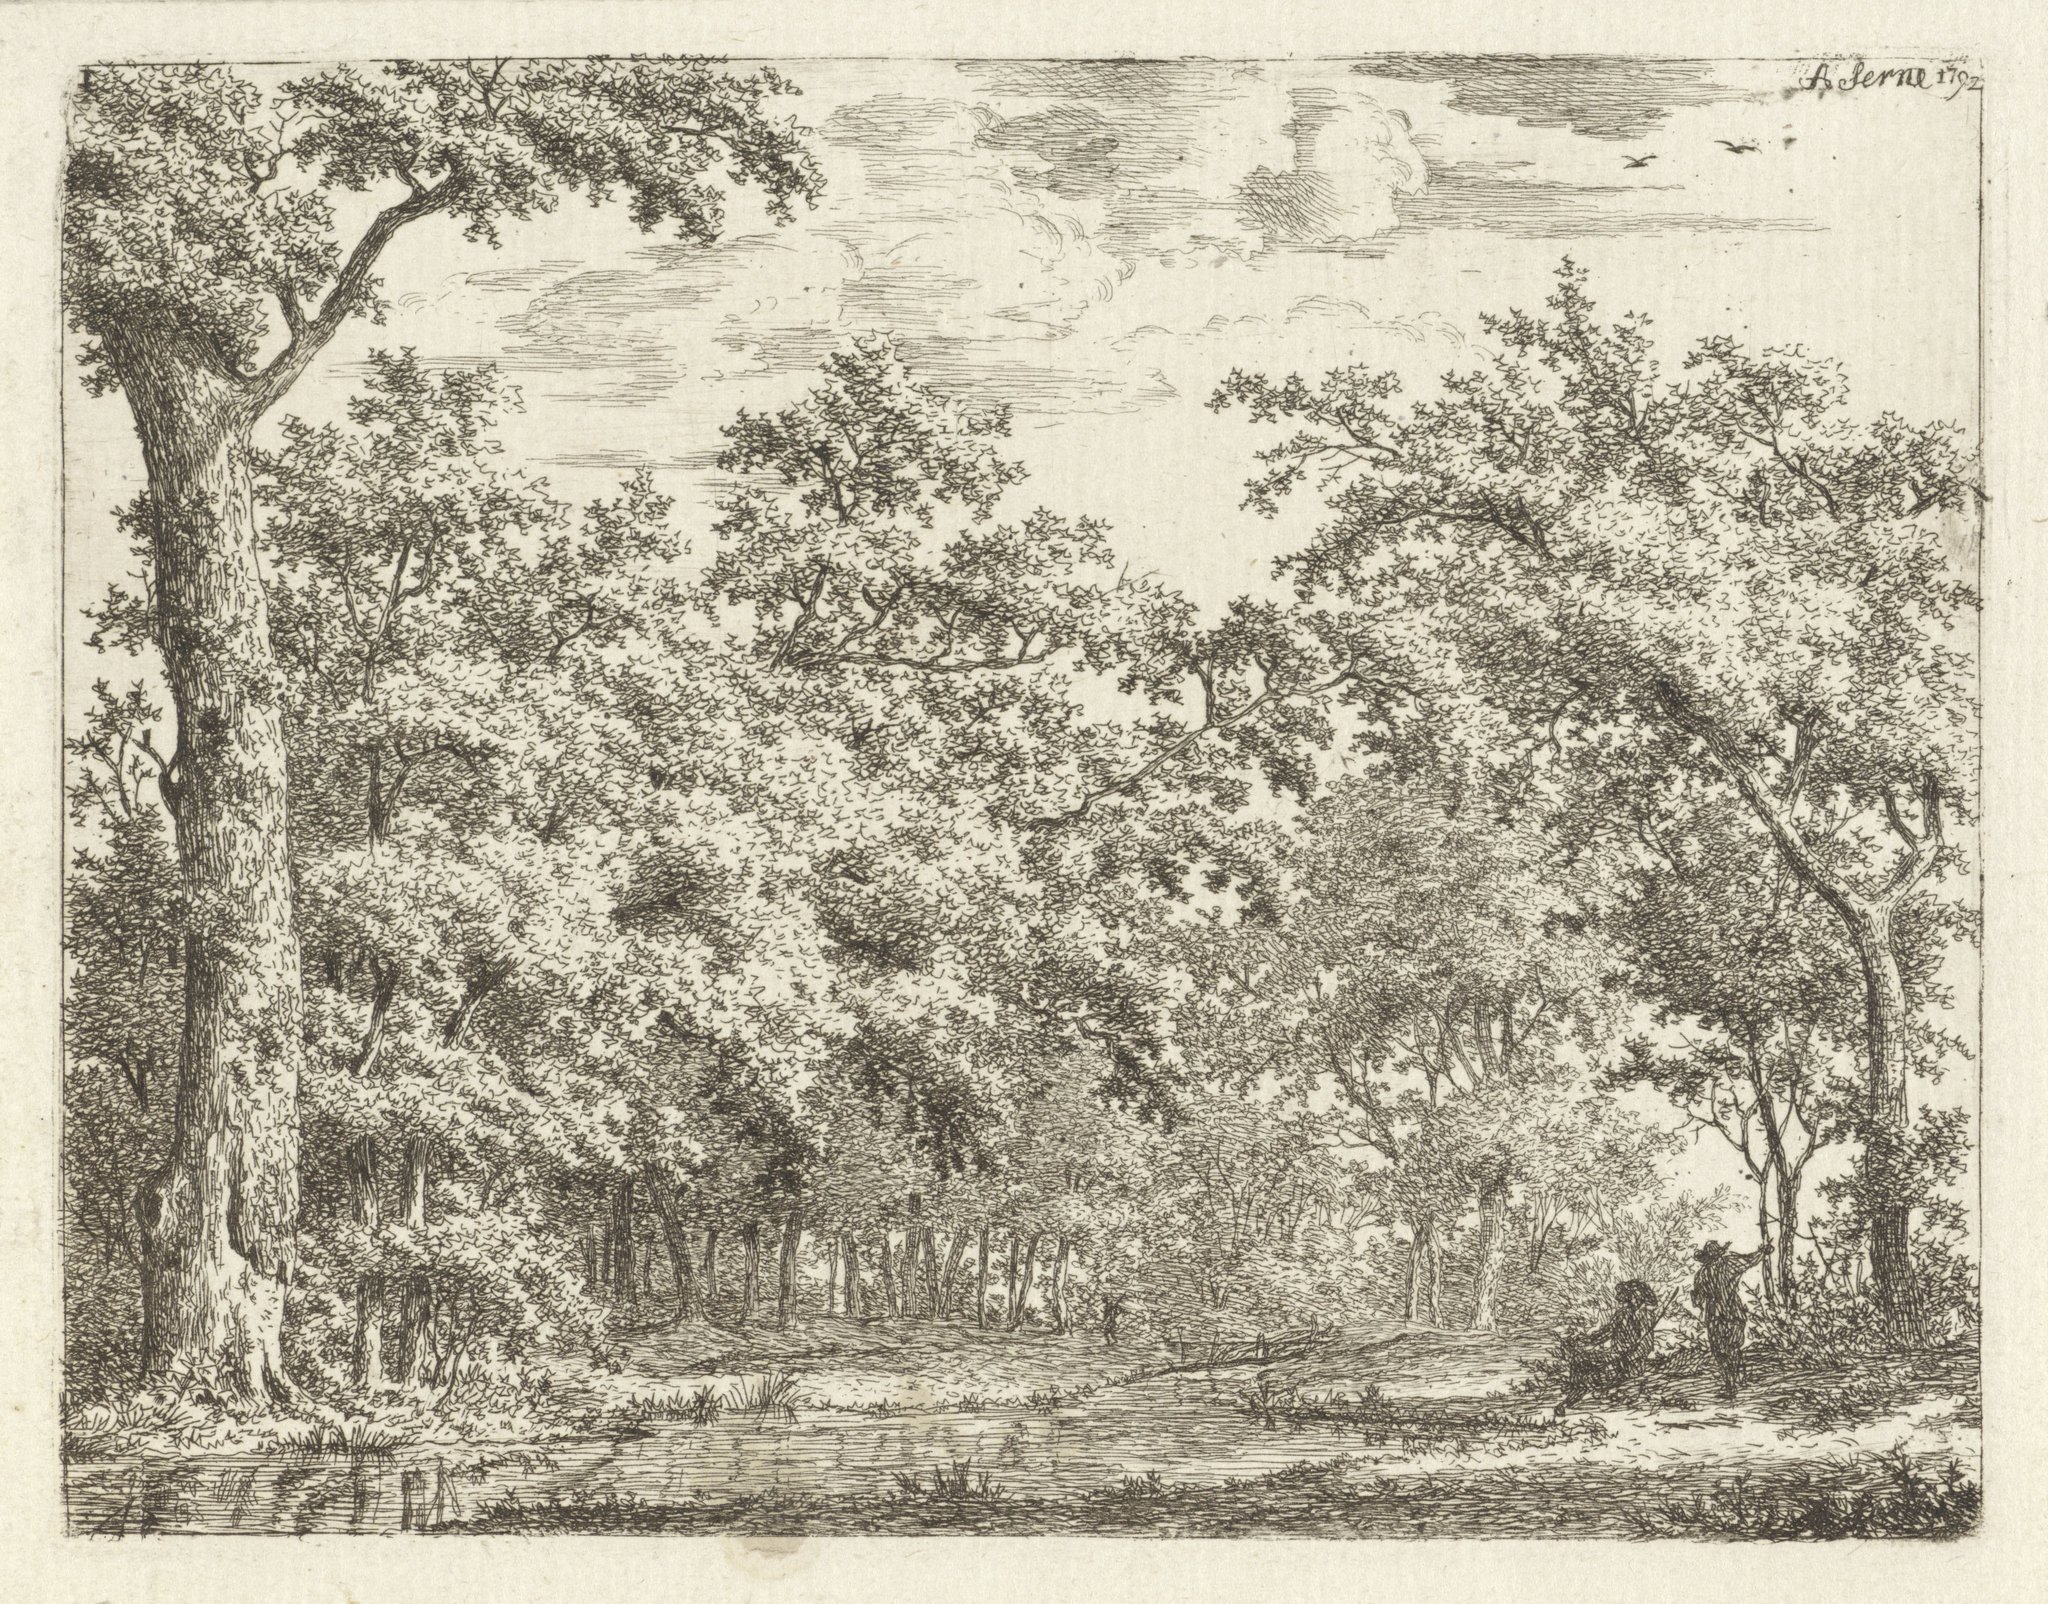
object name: print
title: Twee figuren bij het water in het bos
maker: adrianus serné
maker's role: print maker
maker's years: 1773-1853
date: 1792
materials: paper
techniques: etching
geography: haarlem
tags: forest, wood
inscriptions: collector's mark: Lugt 2228